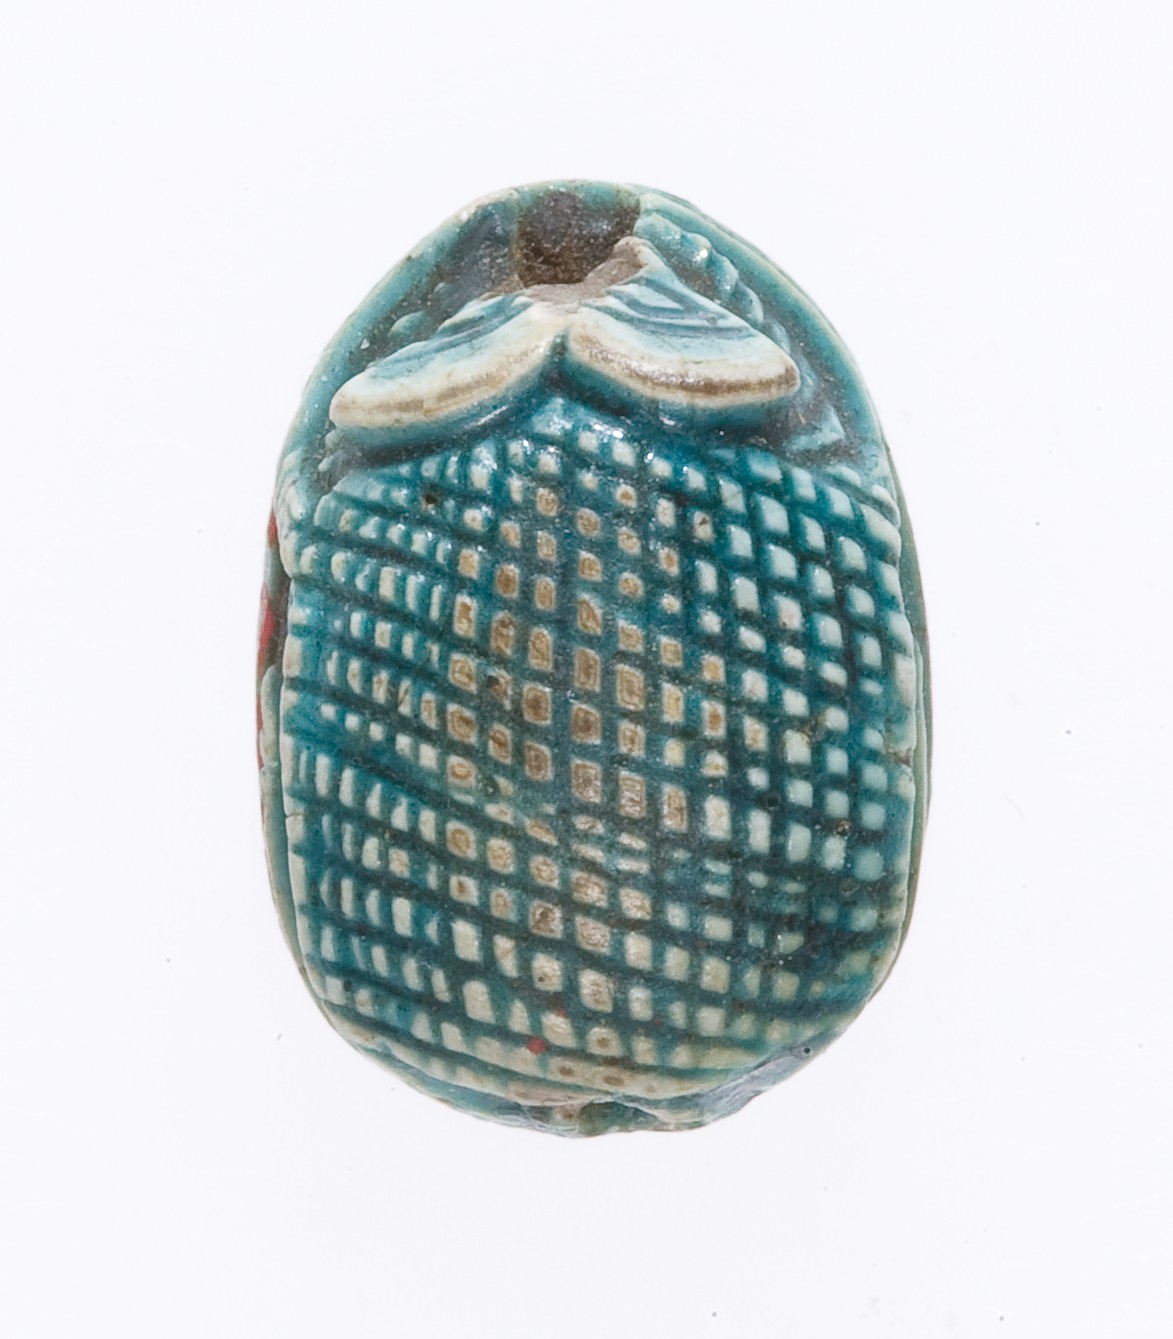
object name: scarab, hedgehog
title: Scarab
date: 2030-1640 BCE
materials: stone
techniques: glazing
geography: egypt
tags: scarabs